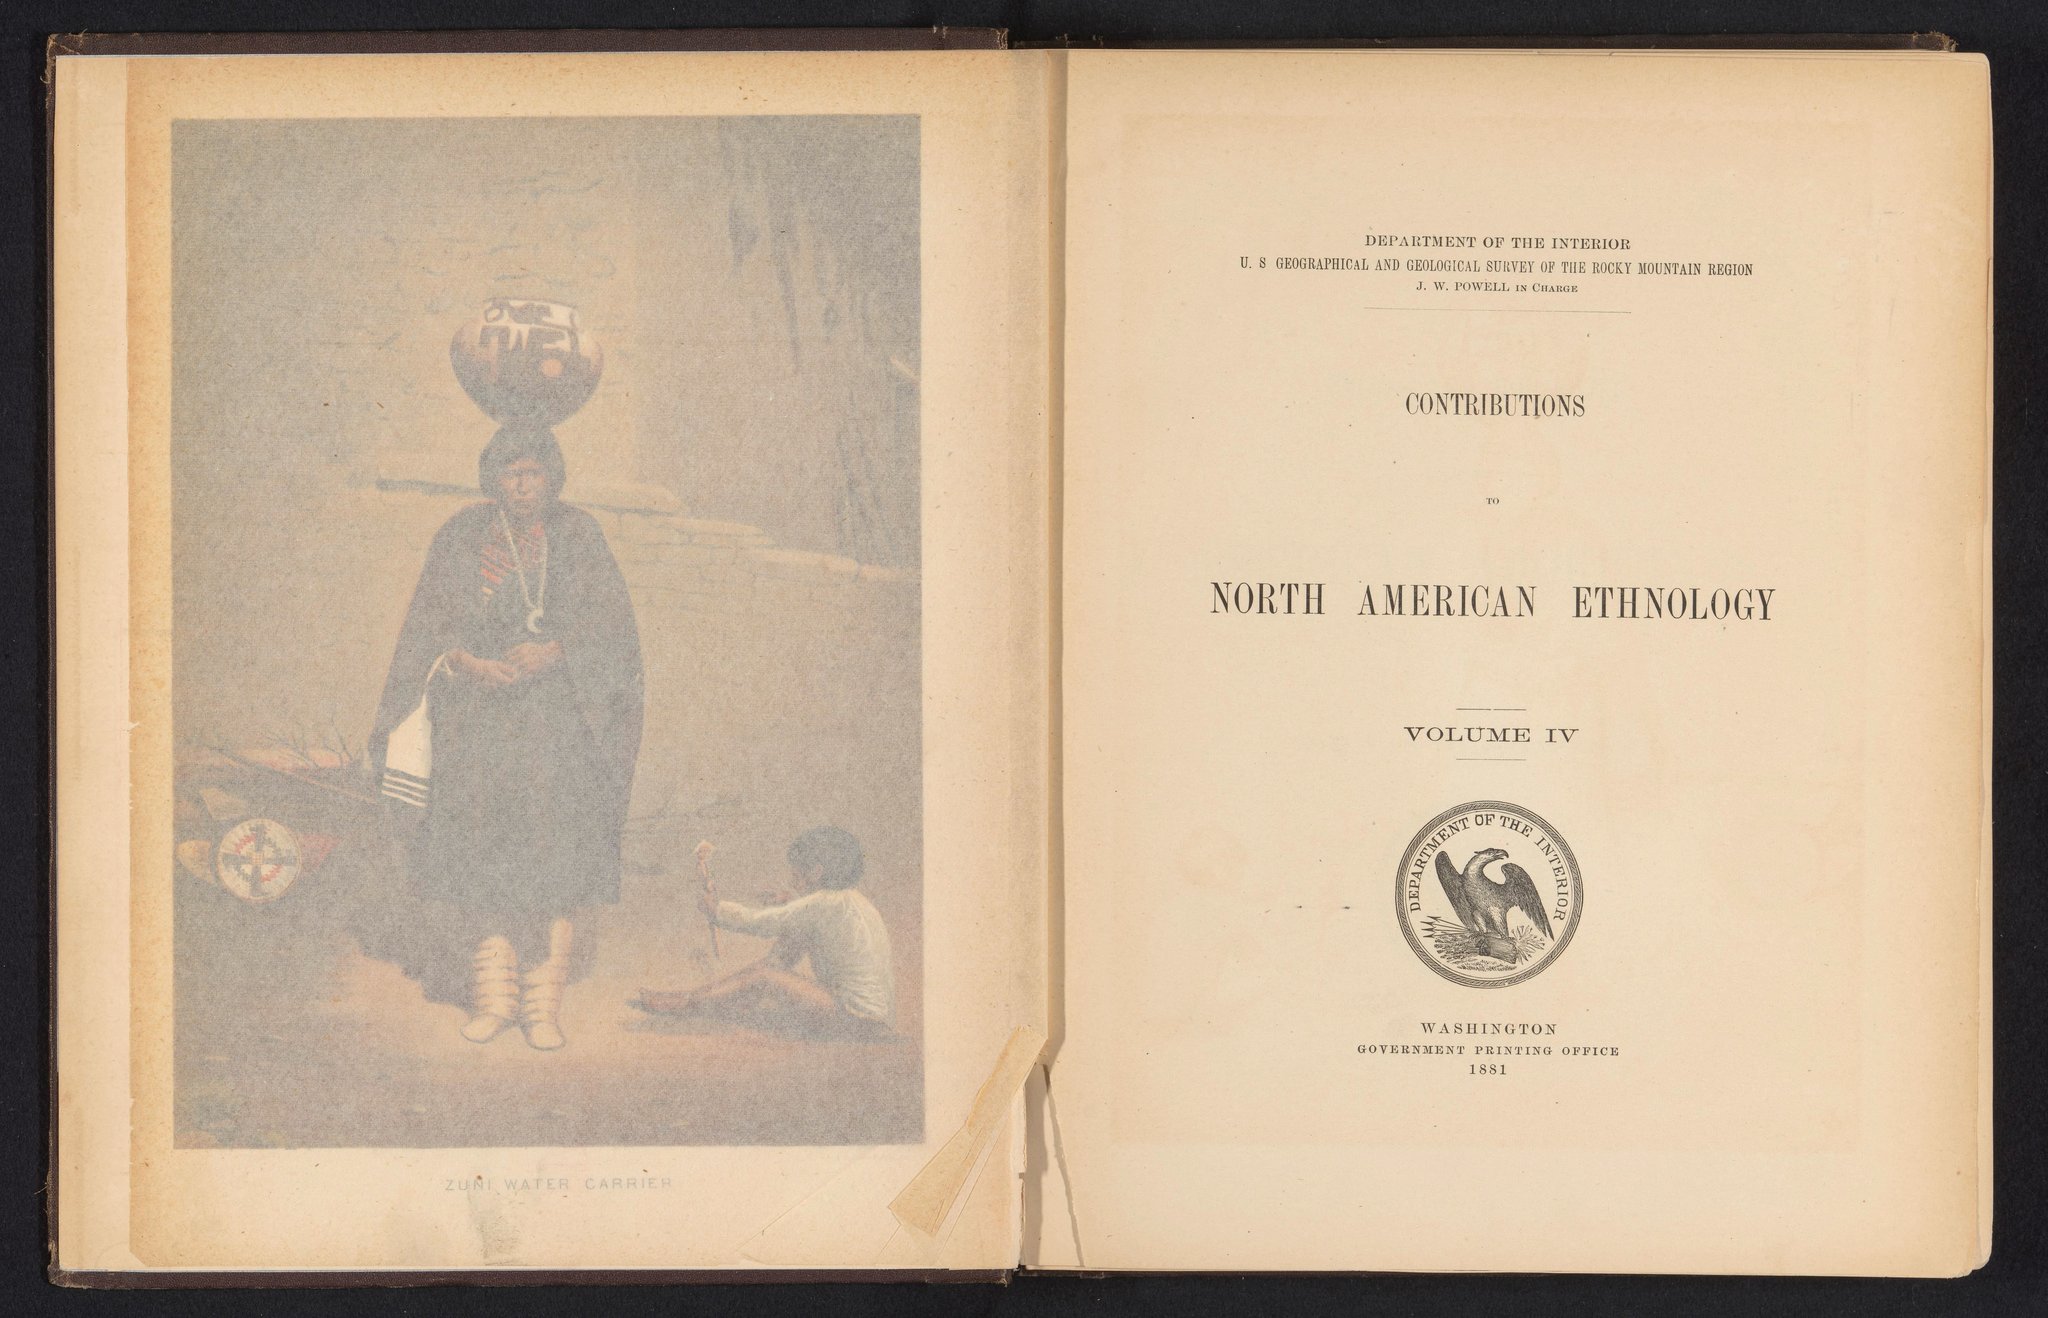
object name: book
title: Houses and house-life of the American aborigines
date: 1881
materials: cardboard, linen, paper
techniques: chromolithography, photograph, printing, engraving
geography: washington d.c.